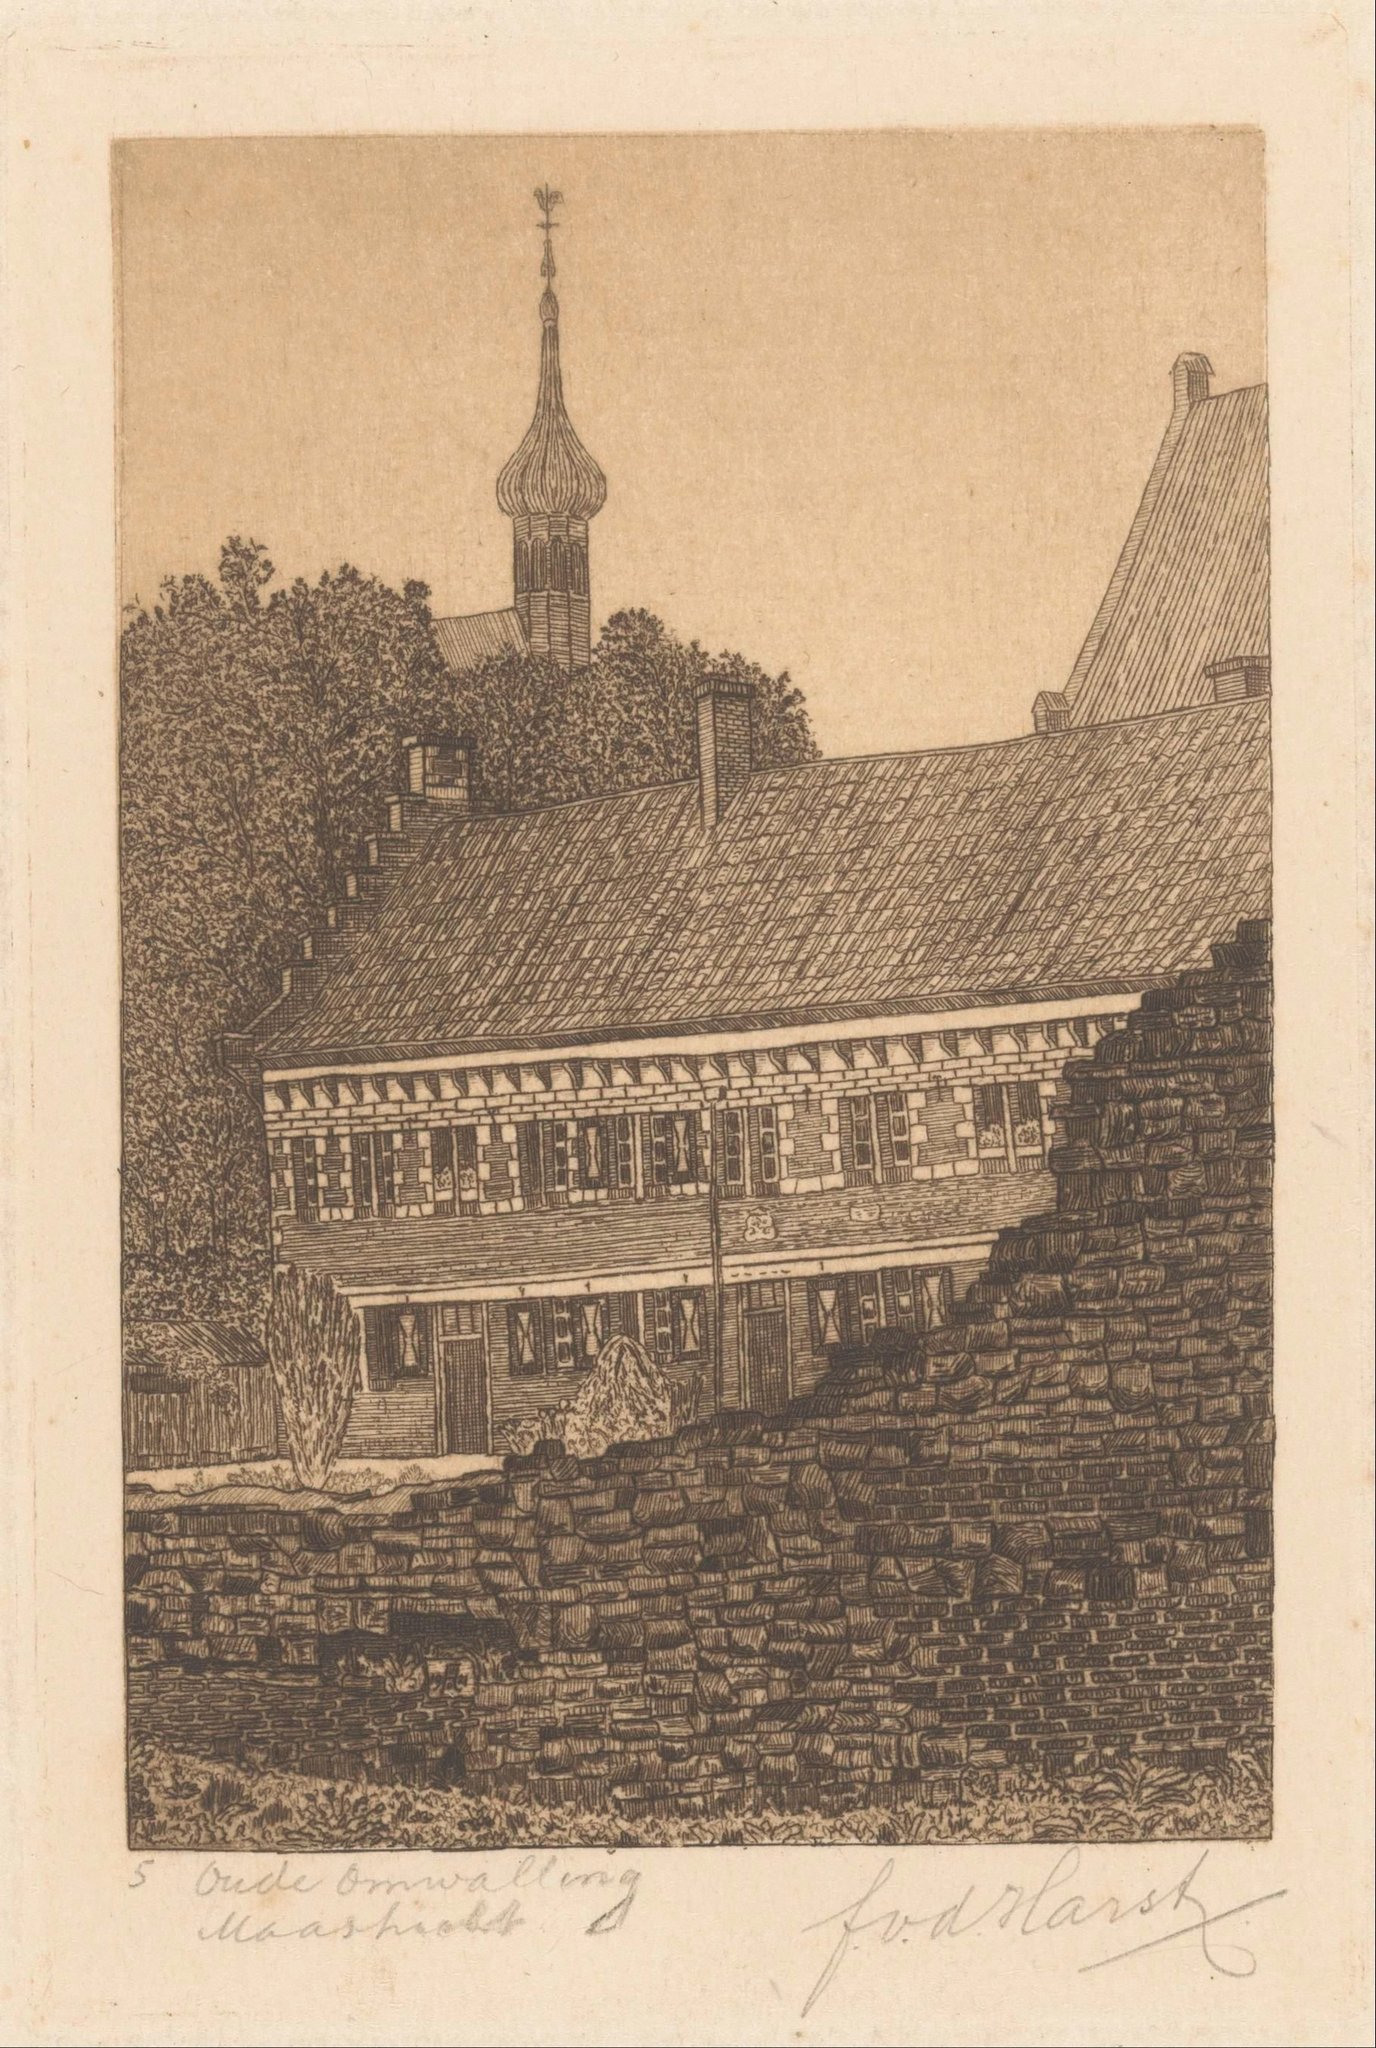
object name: print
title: Oude omwalling, Maastricht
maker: frederik van der harst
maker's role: print maker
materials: paper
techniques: etching, intaglio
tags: abbey, monastery, convent ~ roman catholic church, city-walls, parts of church exterior and annexes, parts of church exterior and annexes: tower, maastricht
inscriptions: number: ‘5’, collector's mark: Lugt 2228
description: Het Faliezustersklooster in Maastricht. Op de voorgrond een stadsmuur. Op de achtergrond de toren van de Waalse Kerk en het dak van de Oude Minderbroederskerk.